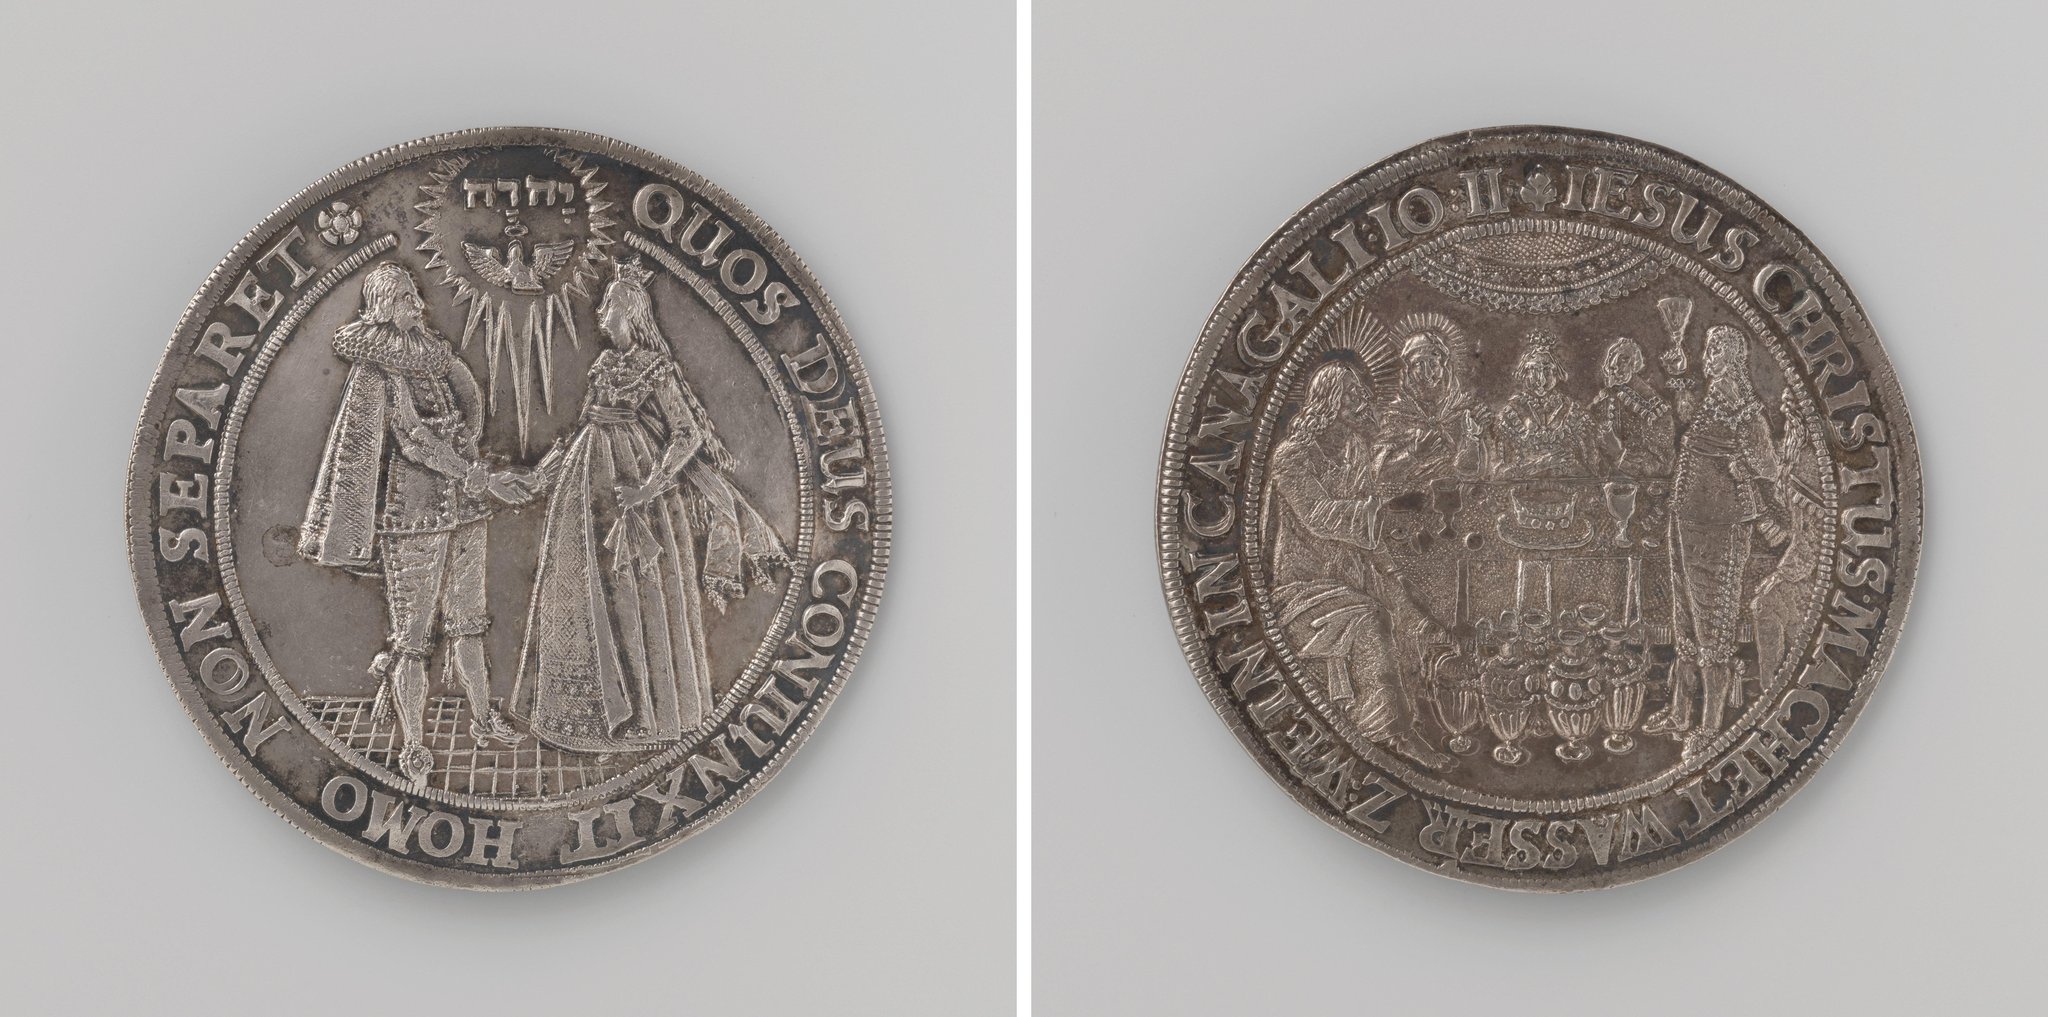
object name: family medal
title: Het huwelijk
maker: Anonymous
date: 1550-1600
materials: silver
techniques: striking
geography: germany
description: Zilveren penning. Voorzijde: man en vrouw reiken elkaar hand, beschenen door hemellicht met daarin naam van Jehovah in Hebreeuws en duif binnen omschrift. Keerzijde: bruiloft van Kanaan binnen omschrift